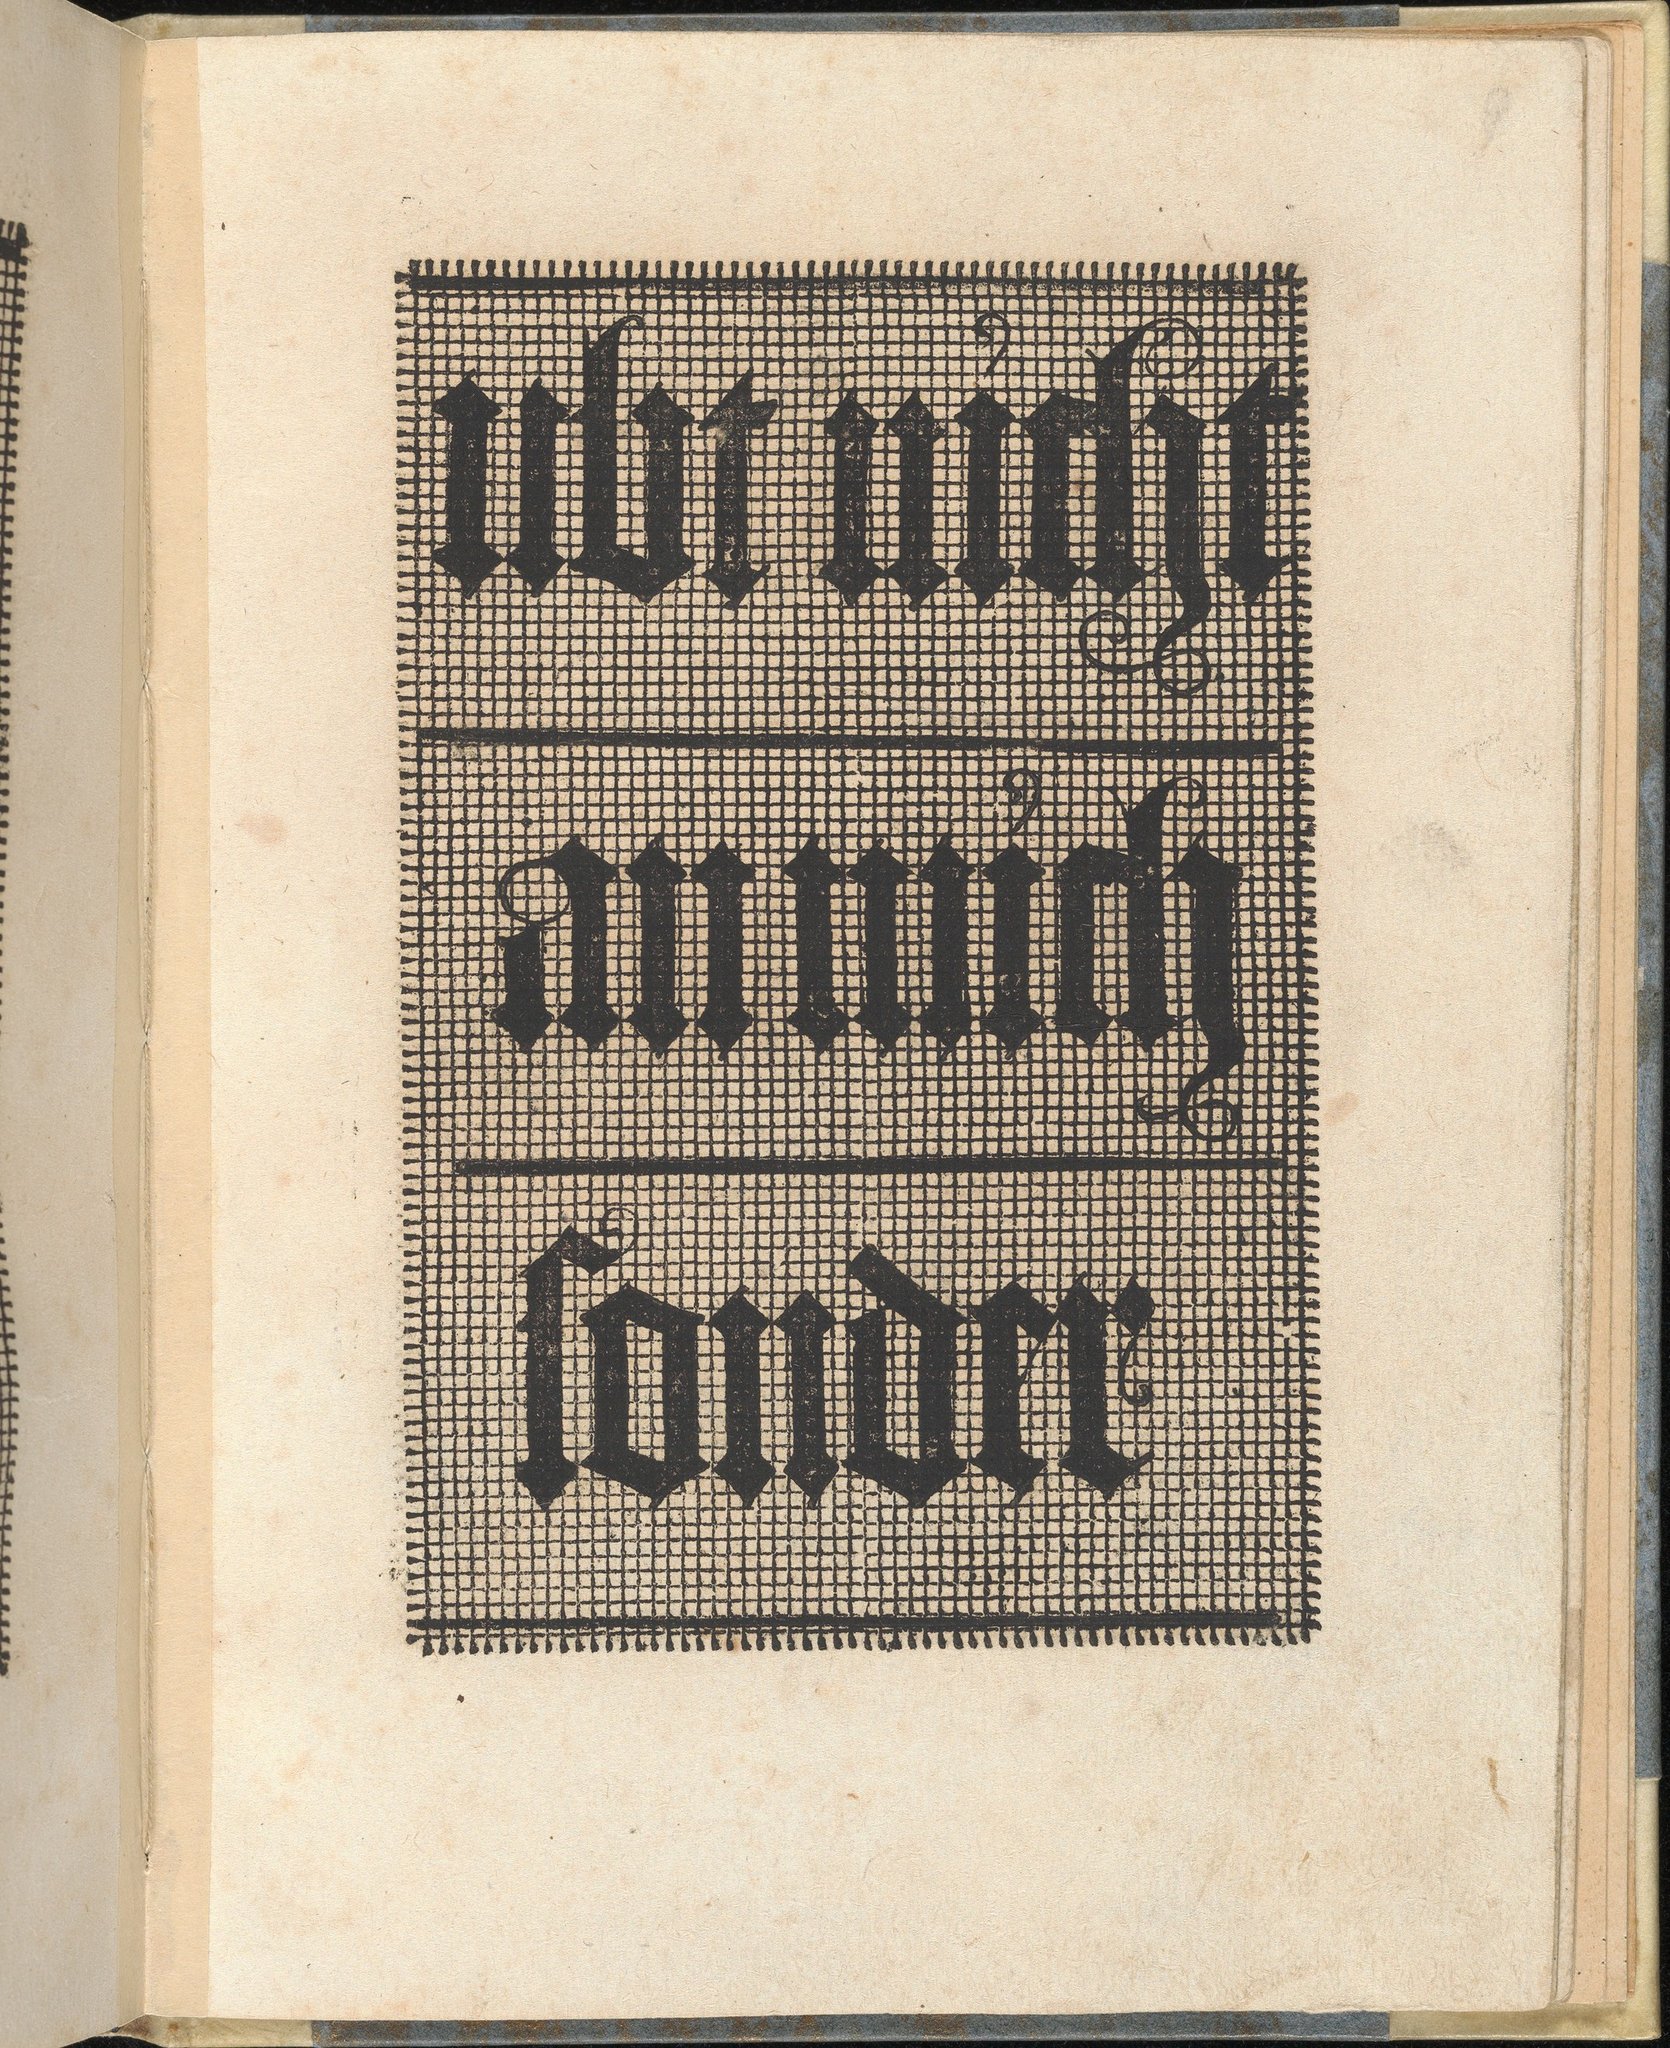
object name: book print ornament architecture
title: Ein ney Furmbüchlein, Page 9, recto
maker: johann schönsperger the younger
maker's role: publisher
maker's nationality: german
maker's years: 1490-1550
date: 1525-1529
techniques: woodcut